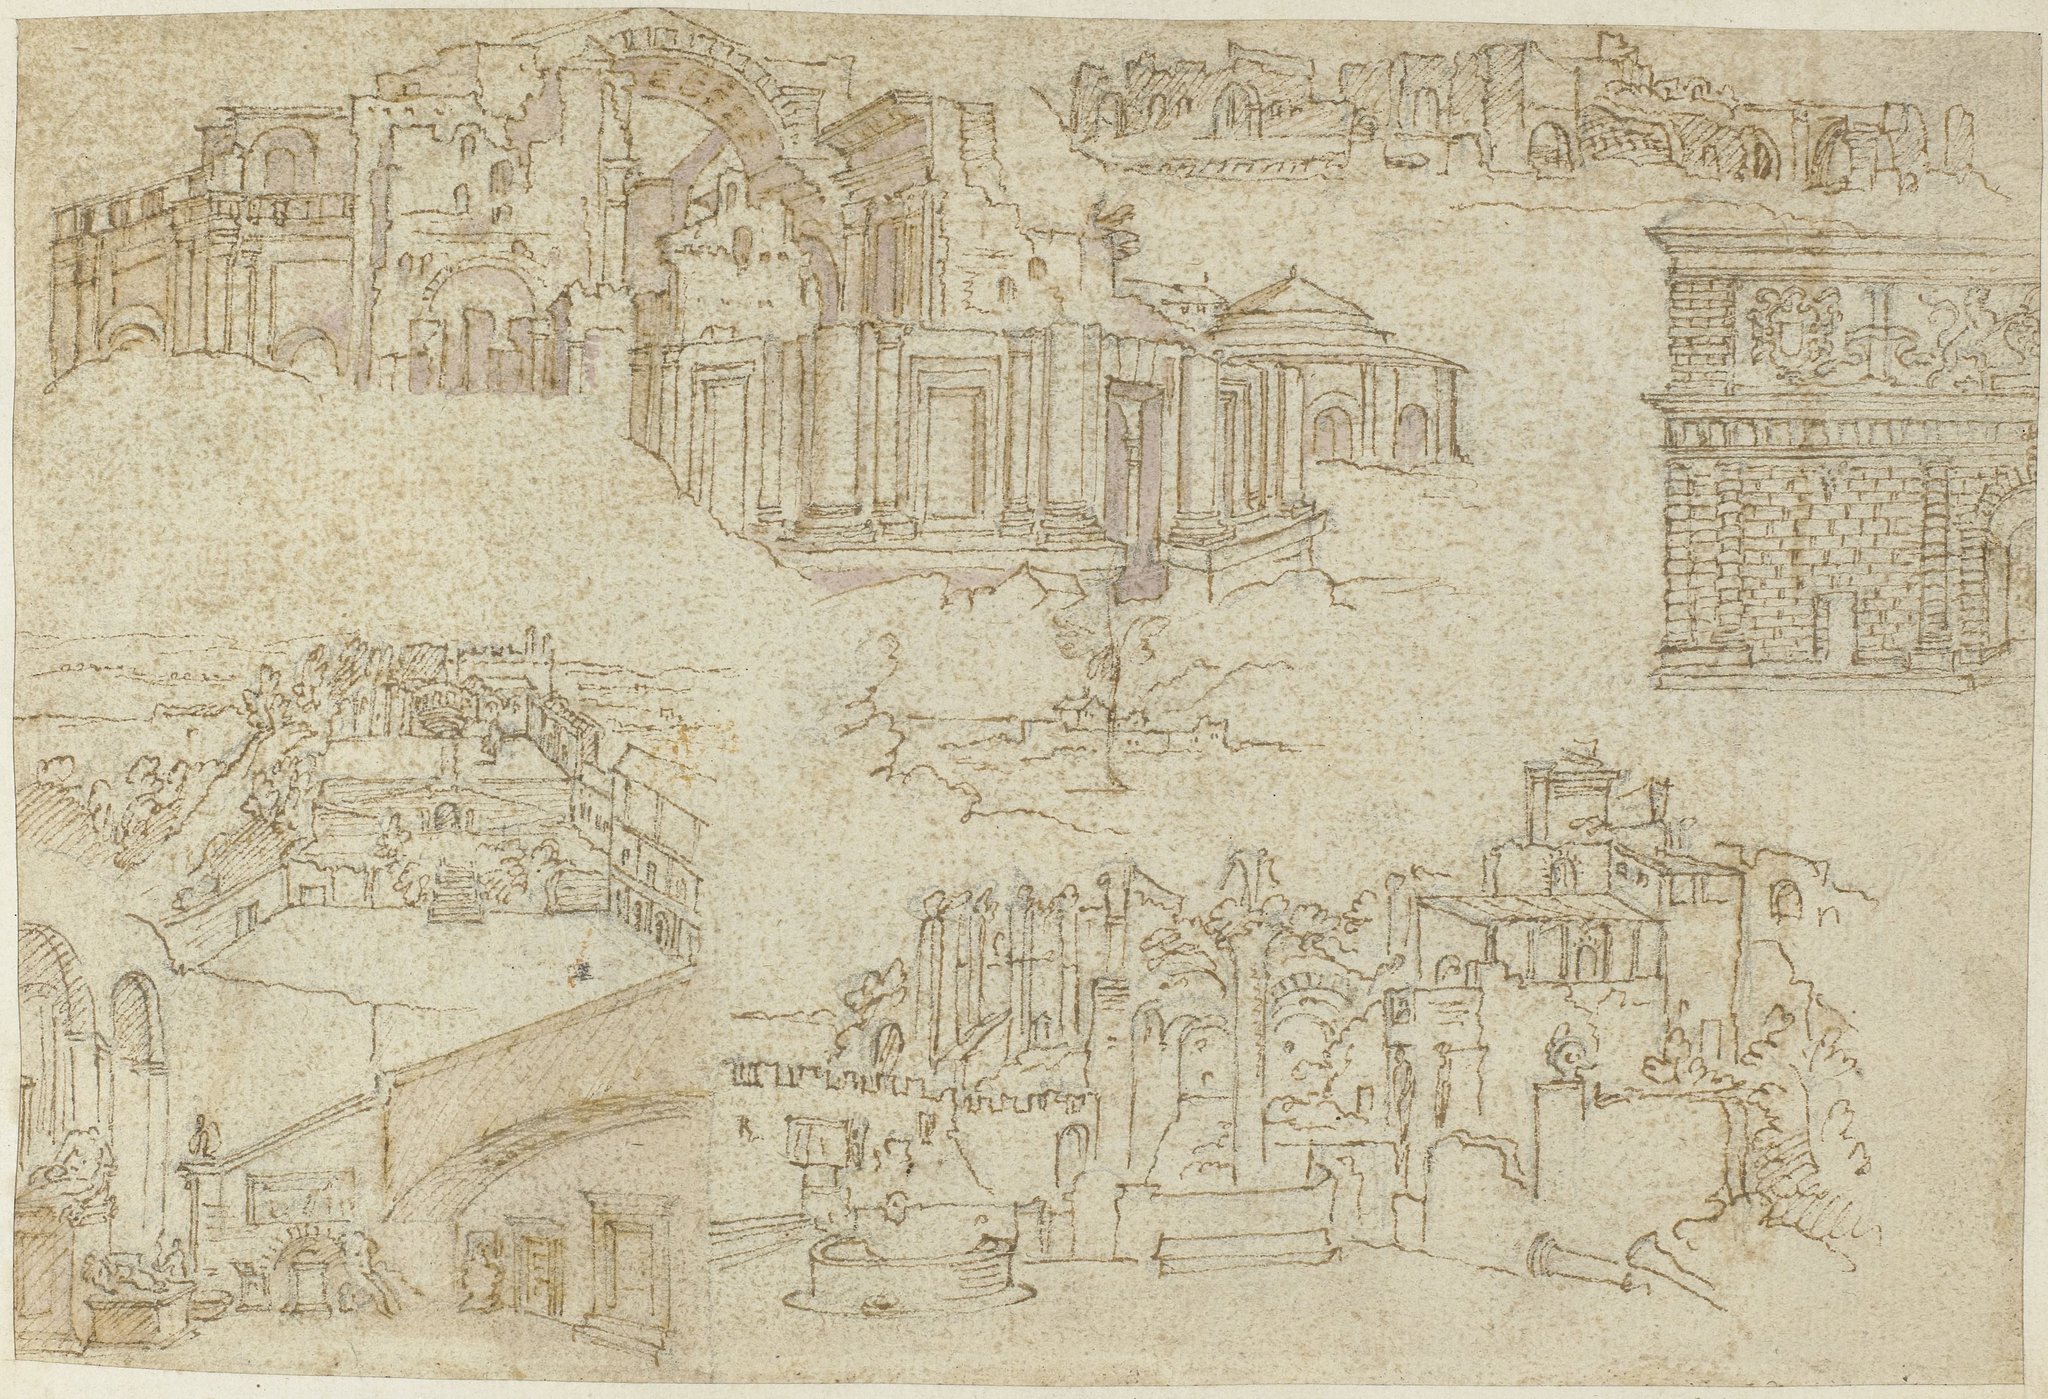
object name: kopie naar tekening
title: Ruïnes en gebouwen in Rome en Antwerpen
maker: Anonymous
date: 1550-1570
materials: chalk, ink, paper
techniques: brush, pen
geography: low countries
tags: antwerp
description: Album "Maarten de Vos schetsboek", blad 9v(12)